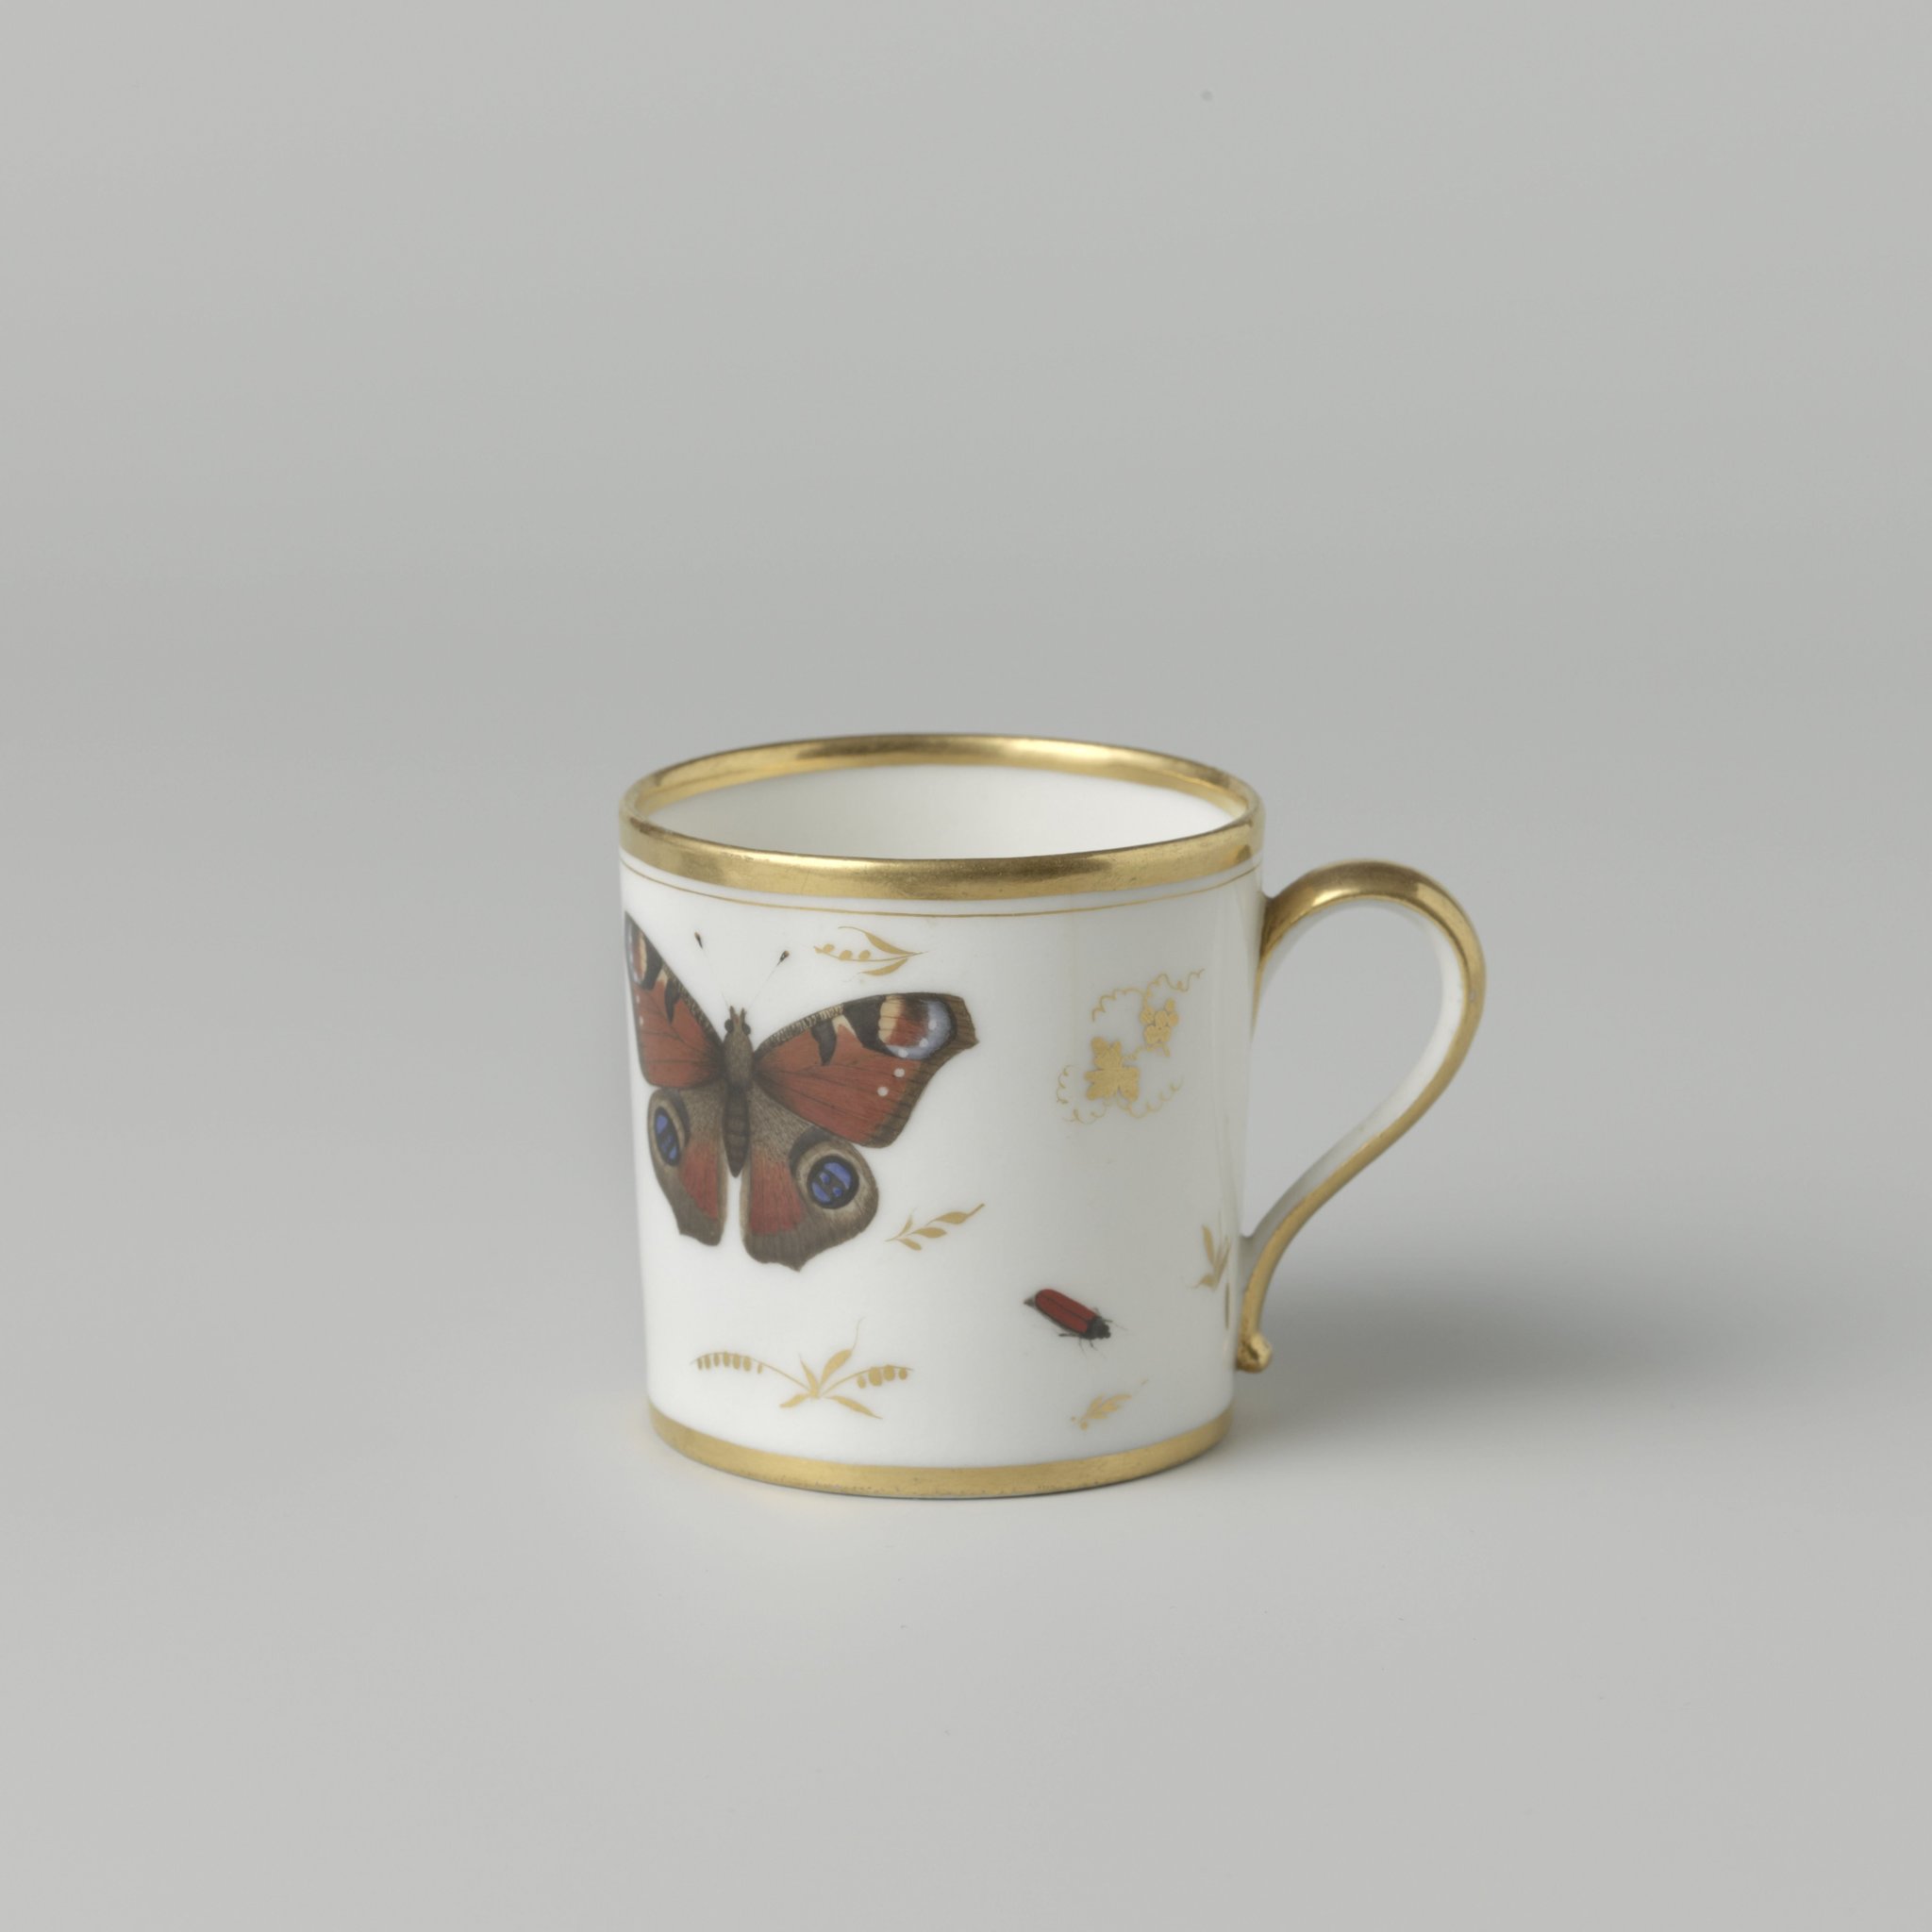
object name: service set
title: Cup with insects, flower sprays and grapevines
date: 1797-1798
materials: glaze, gold, paint, porcelain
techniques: firing, forming, gilding, turning, vitrification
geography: paris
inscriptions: mark: ‘2’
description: Kop van porselein met een cilindrische wand en C-vormig oor, beschilderd op het glazuur in emailkleuren en goud. De buitenwand is bedekt met gekleurde insecten (vlinders, kevers, libellen, etc.) en in goud bloemtakken en druivenranken. Gouden rand en oor. Gemerkt op de onderzijde met 2.